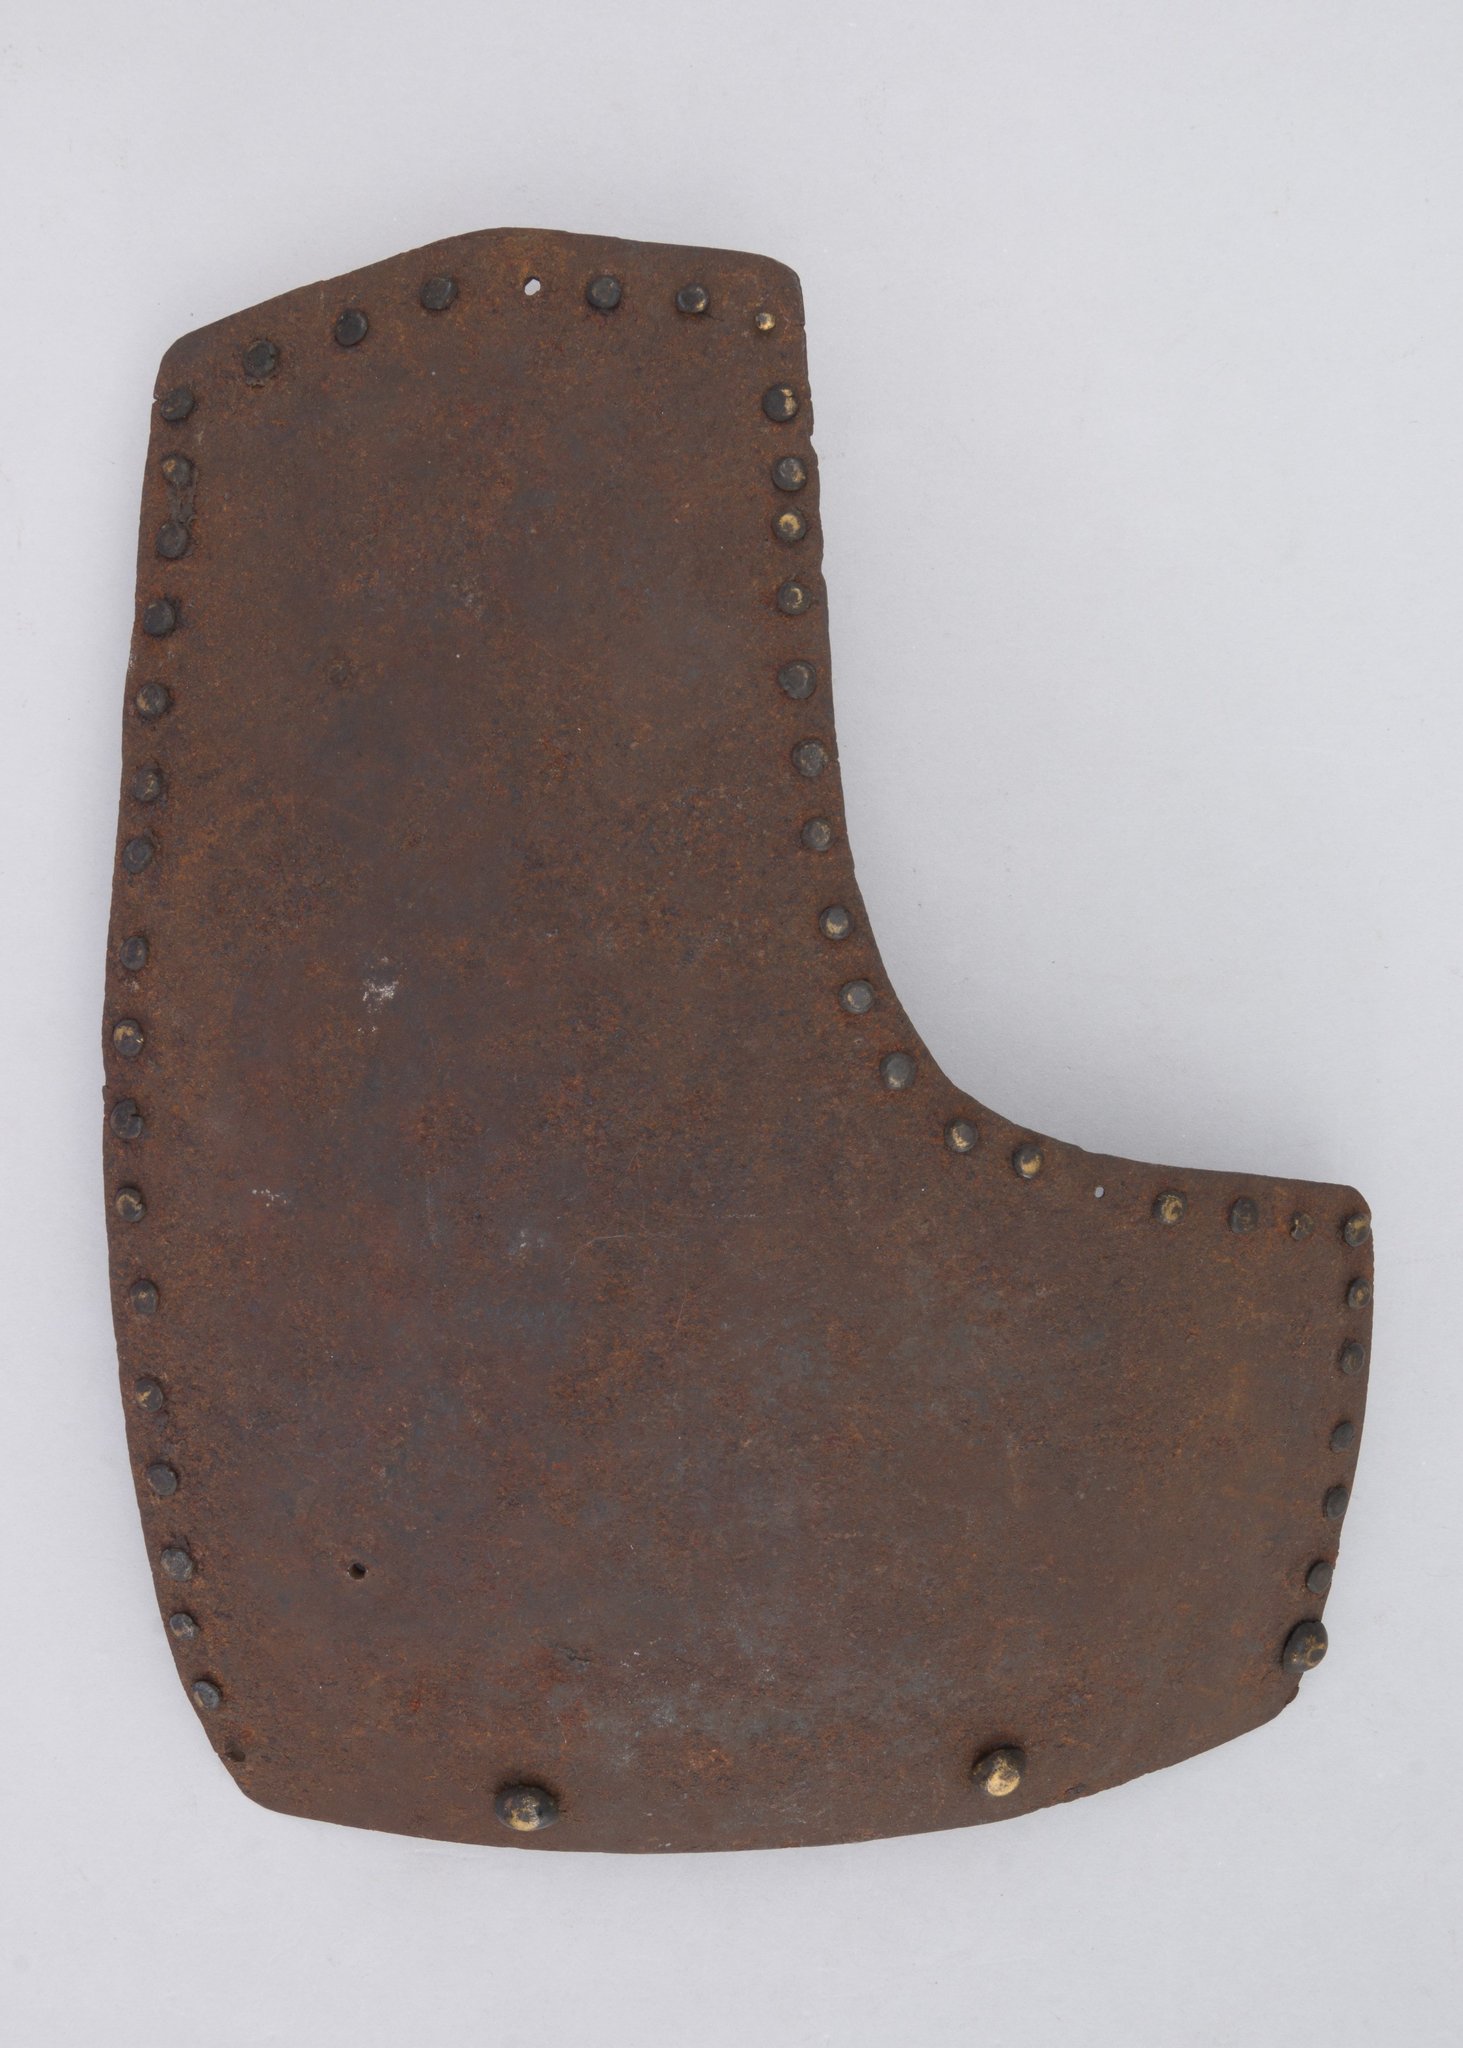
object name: brigandine plate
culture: italian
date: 1400-1450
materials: copper alloy, metal alloy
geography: italy